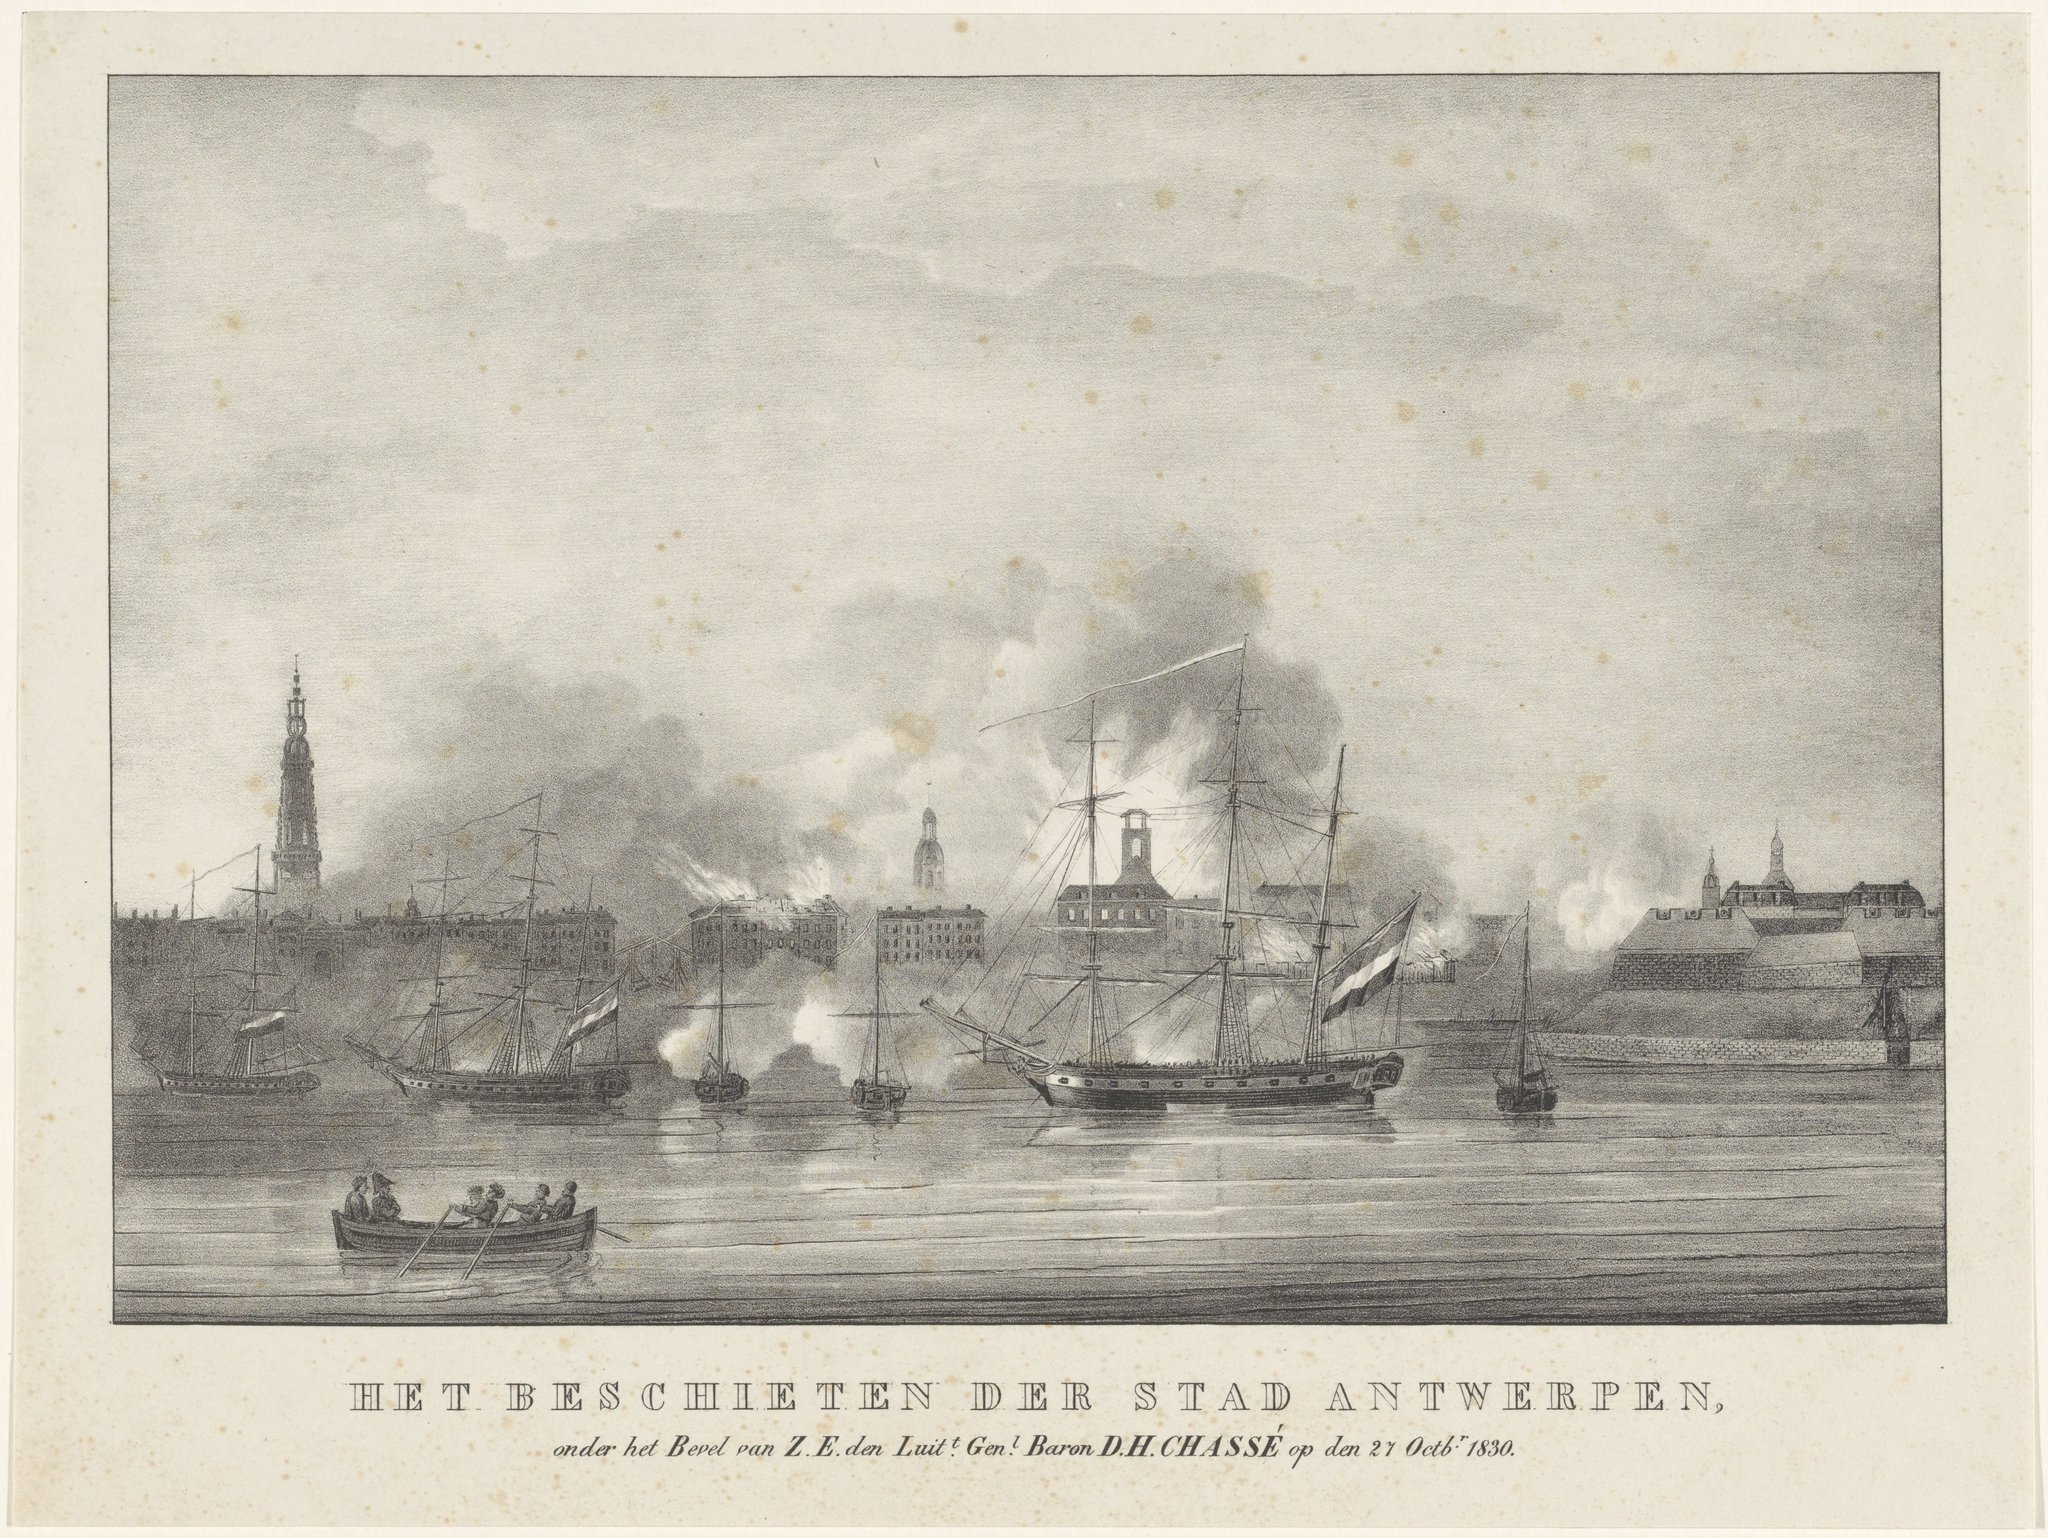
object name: print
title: Het beschieten der stad Antwerpen, onder het Bevel van Z.E. den Luit.t Gen.l Baron D.H. Chassé op den 27 Octb.r 1830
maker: Anonymous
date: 1830-1831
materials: paper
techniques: lithograph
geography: netherlands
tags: david hendrik baron chassé, bombardment ~ siege, bombardment, antwerp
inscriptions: collector's mark: Lugt 2228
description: Bombardement van Antwerpen door Nederlandse oorlogsschepen onder bevel van baron Chassé, op 27 oktober 1830. Op de Schelde de drie fregatten: de Gier, Comeet en Euridice en enkele kleinere boten. Bij een ander exemplaar van deze prent behoort een kleinere prent met de sleutel tot de voorstelling, met de namen van de schepen en belangrijkste gebouwen.